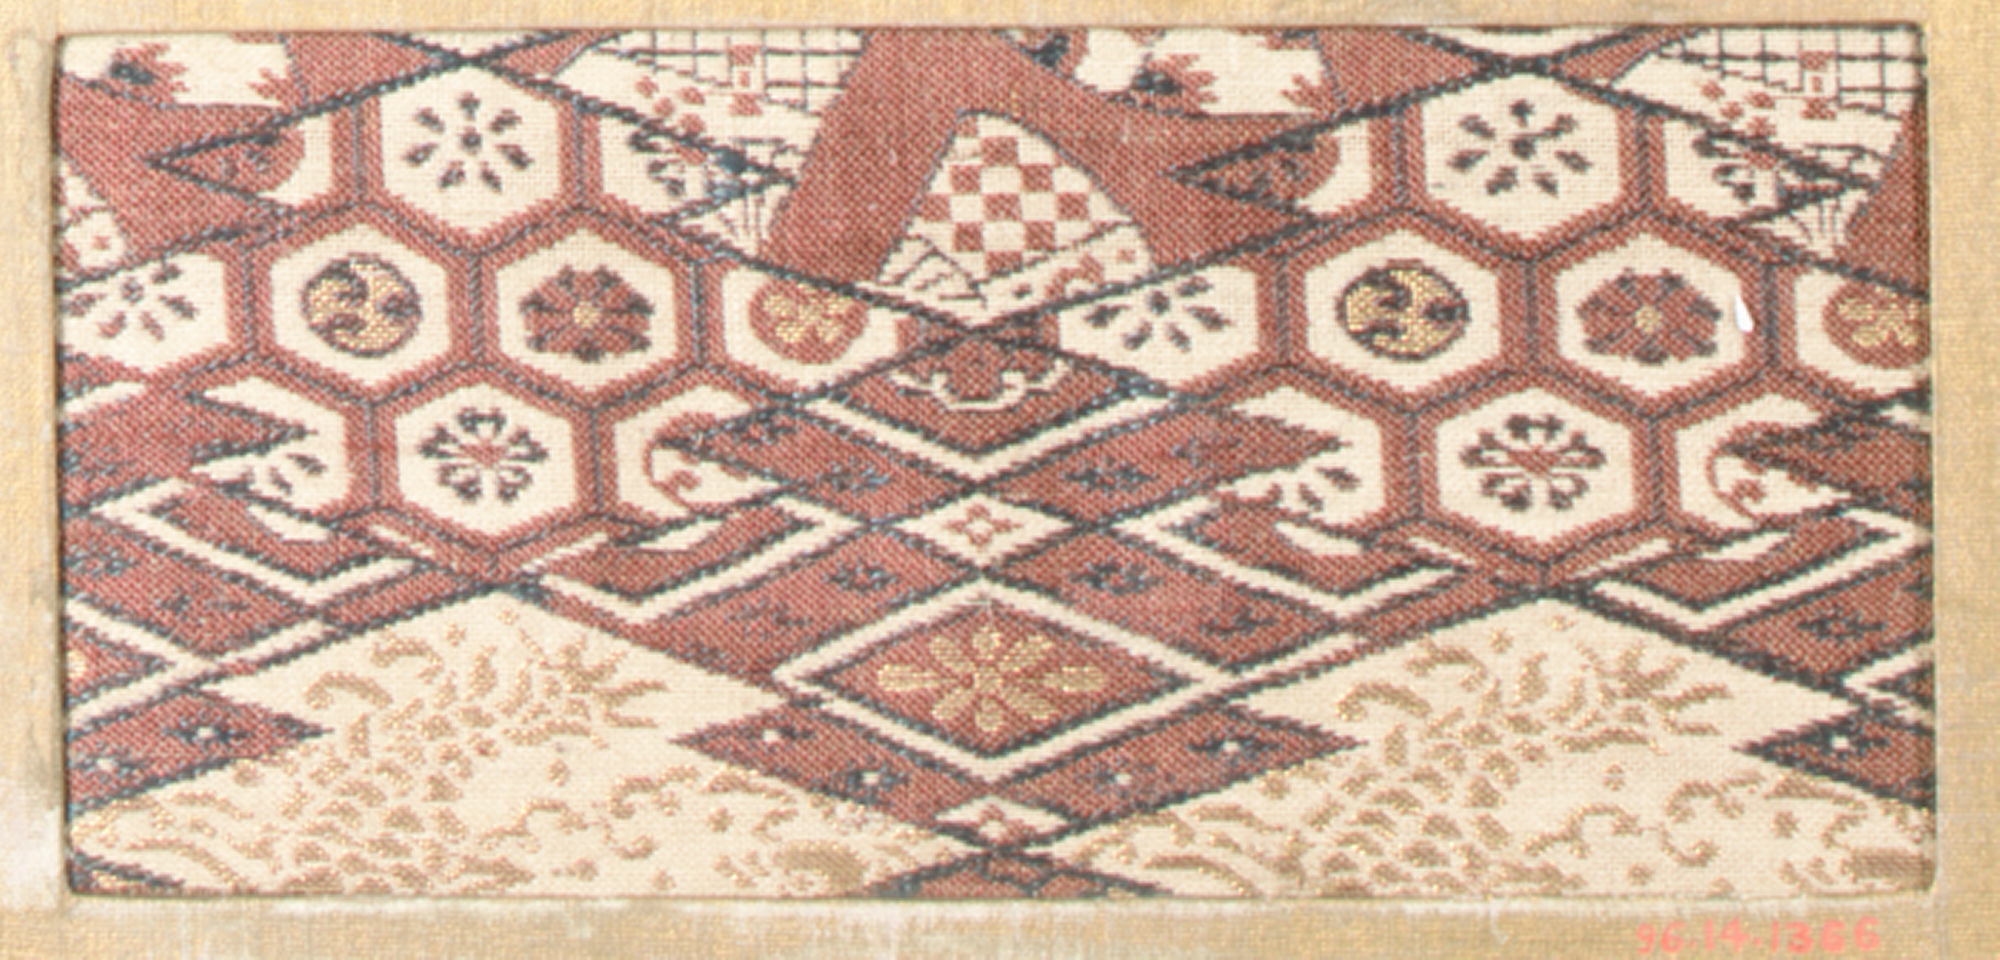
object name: piece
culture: japanese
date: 1701-1900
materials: silk